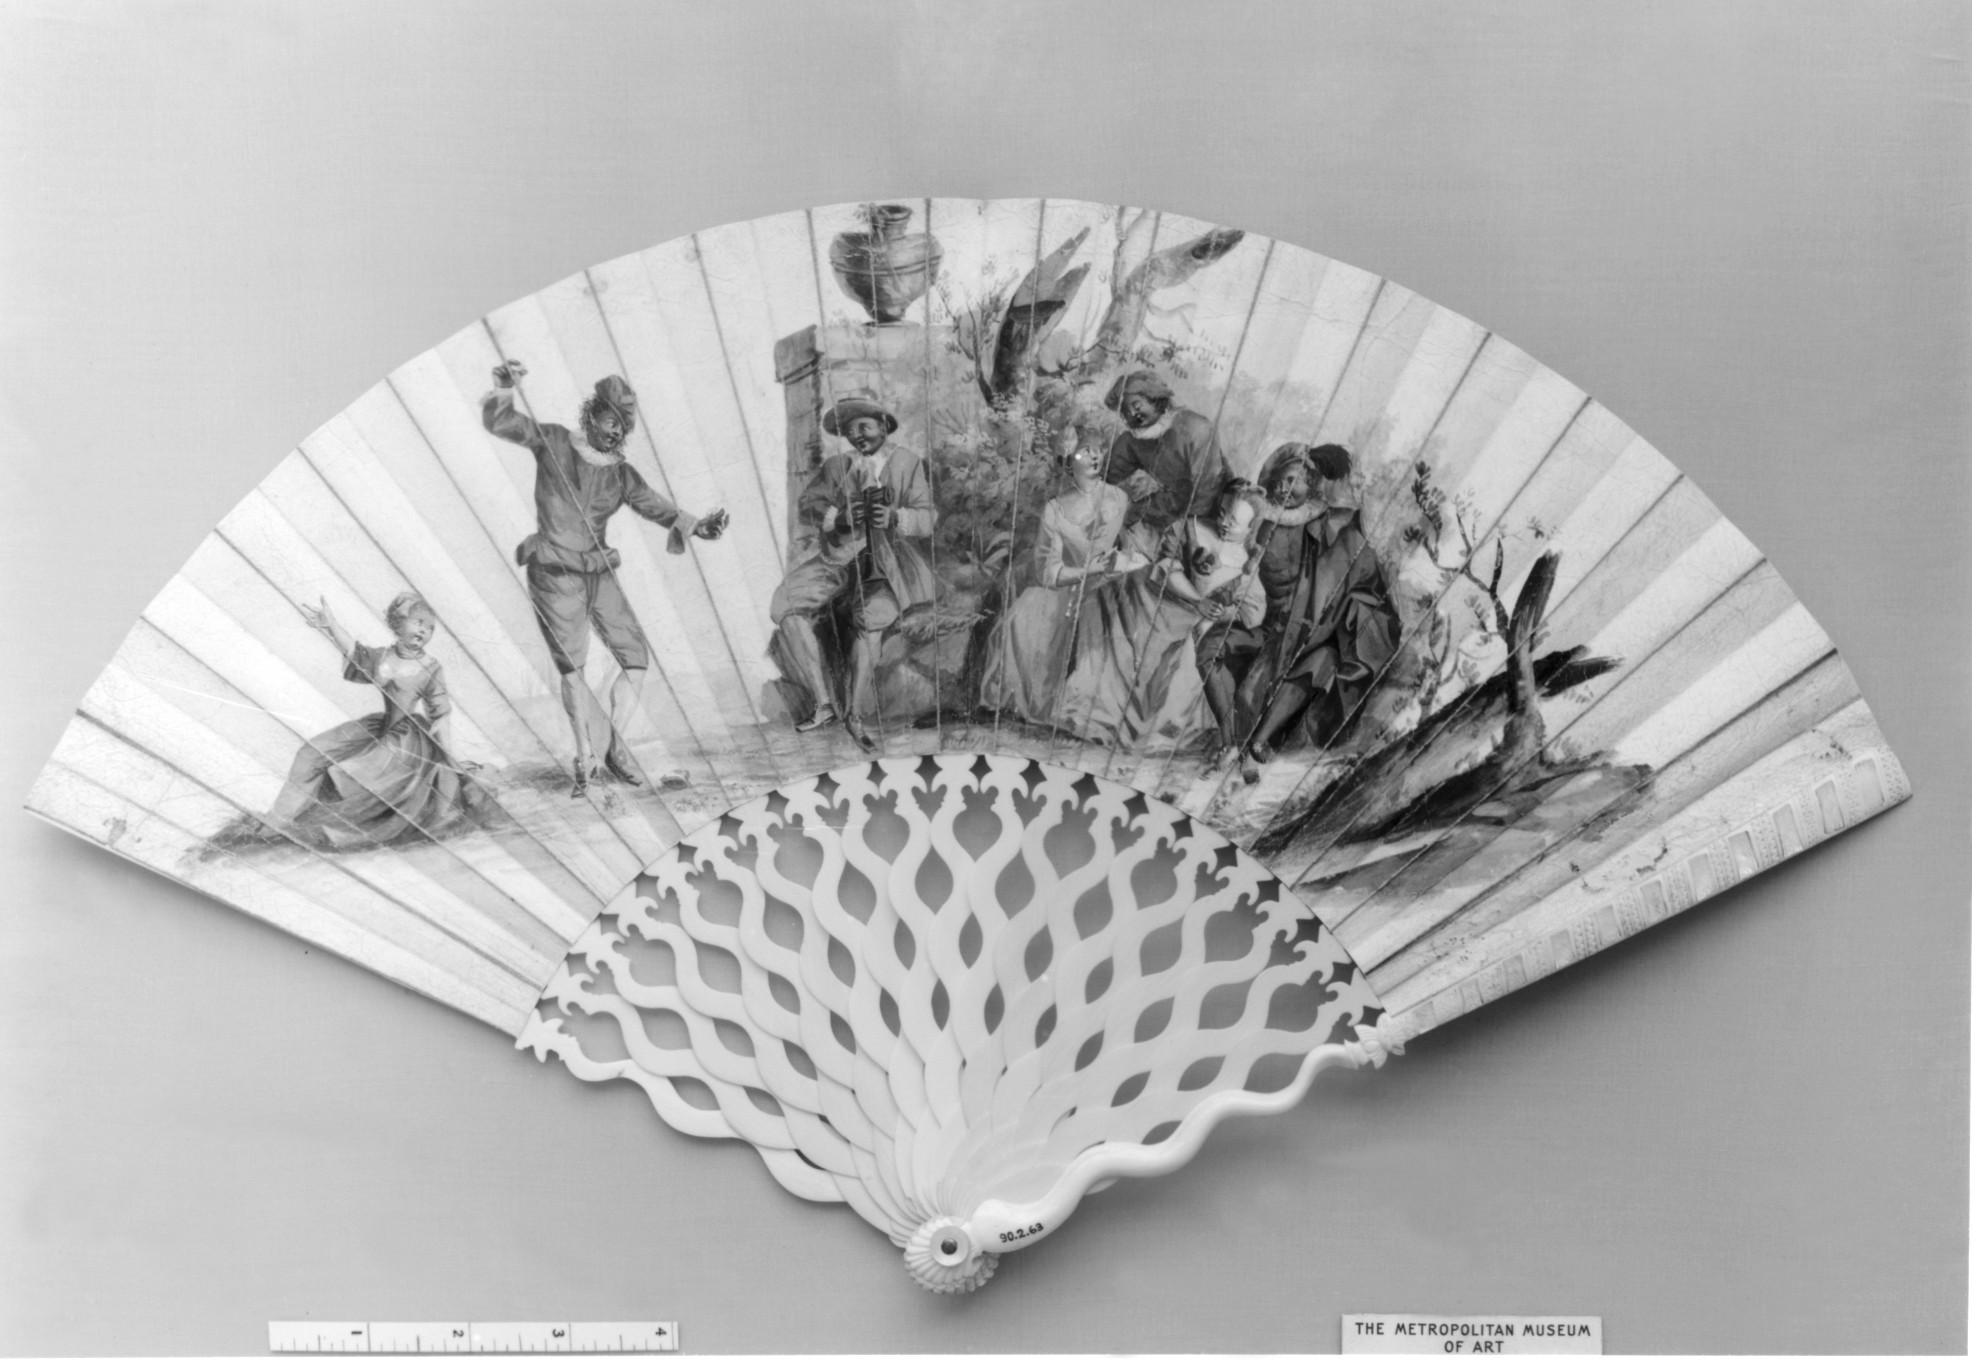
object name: fan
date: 1725-1750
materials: ivory, mother of pearl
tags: men,women